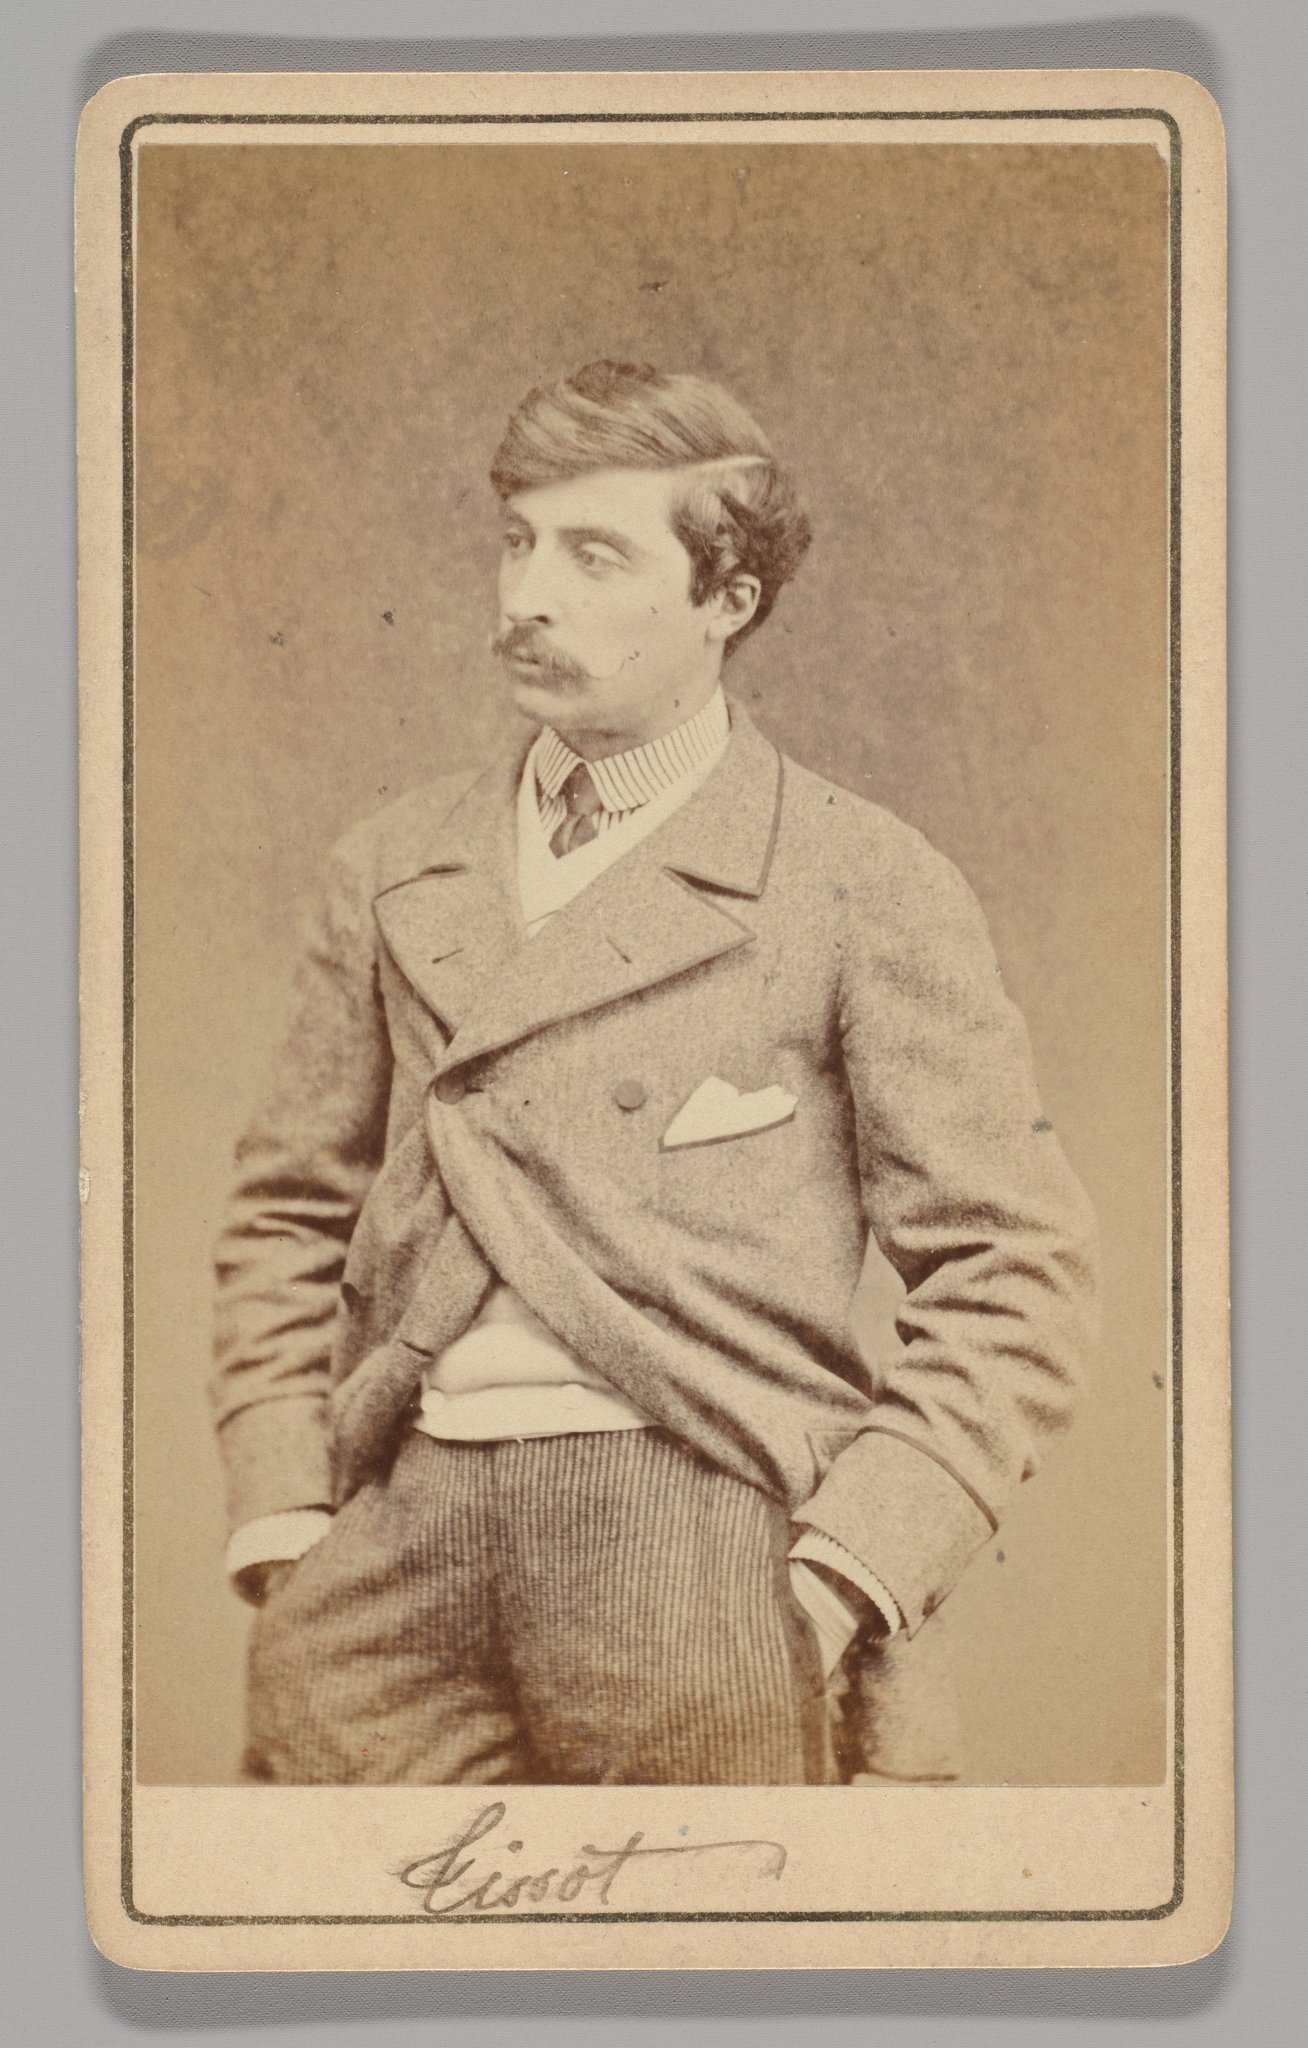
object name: carte de visite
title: James Tissot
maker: robert jefferson bingham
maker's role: printer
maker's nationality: british, active france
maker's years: 1824-1870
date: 1861-1870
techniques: albumen silver print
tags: men,portraits,artists